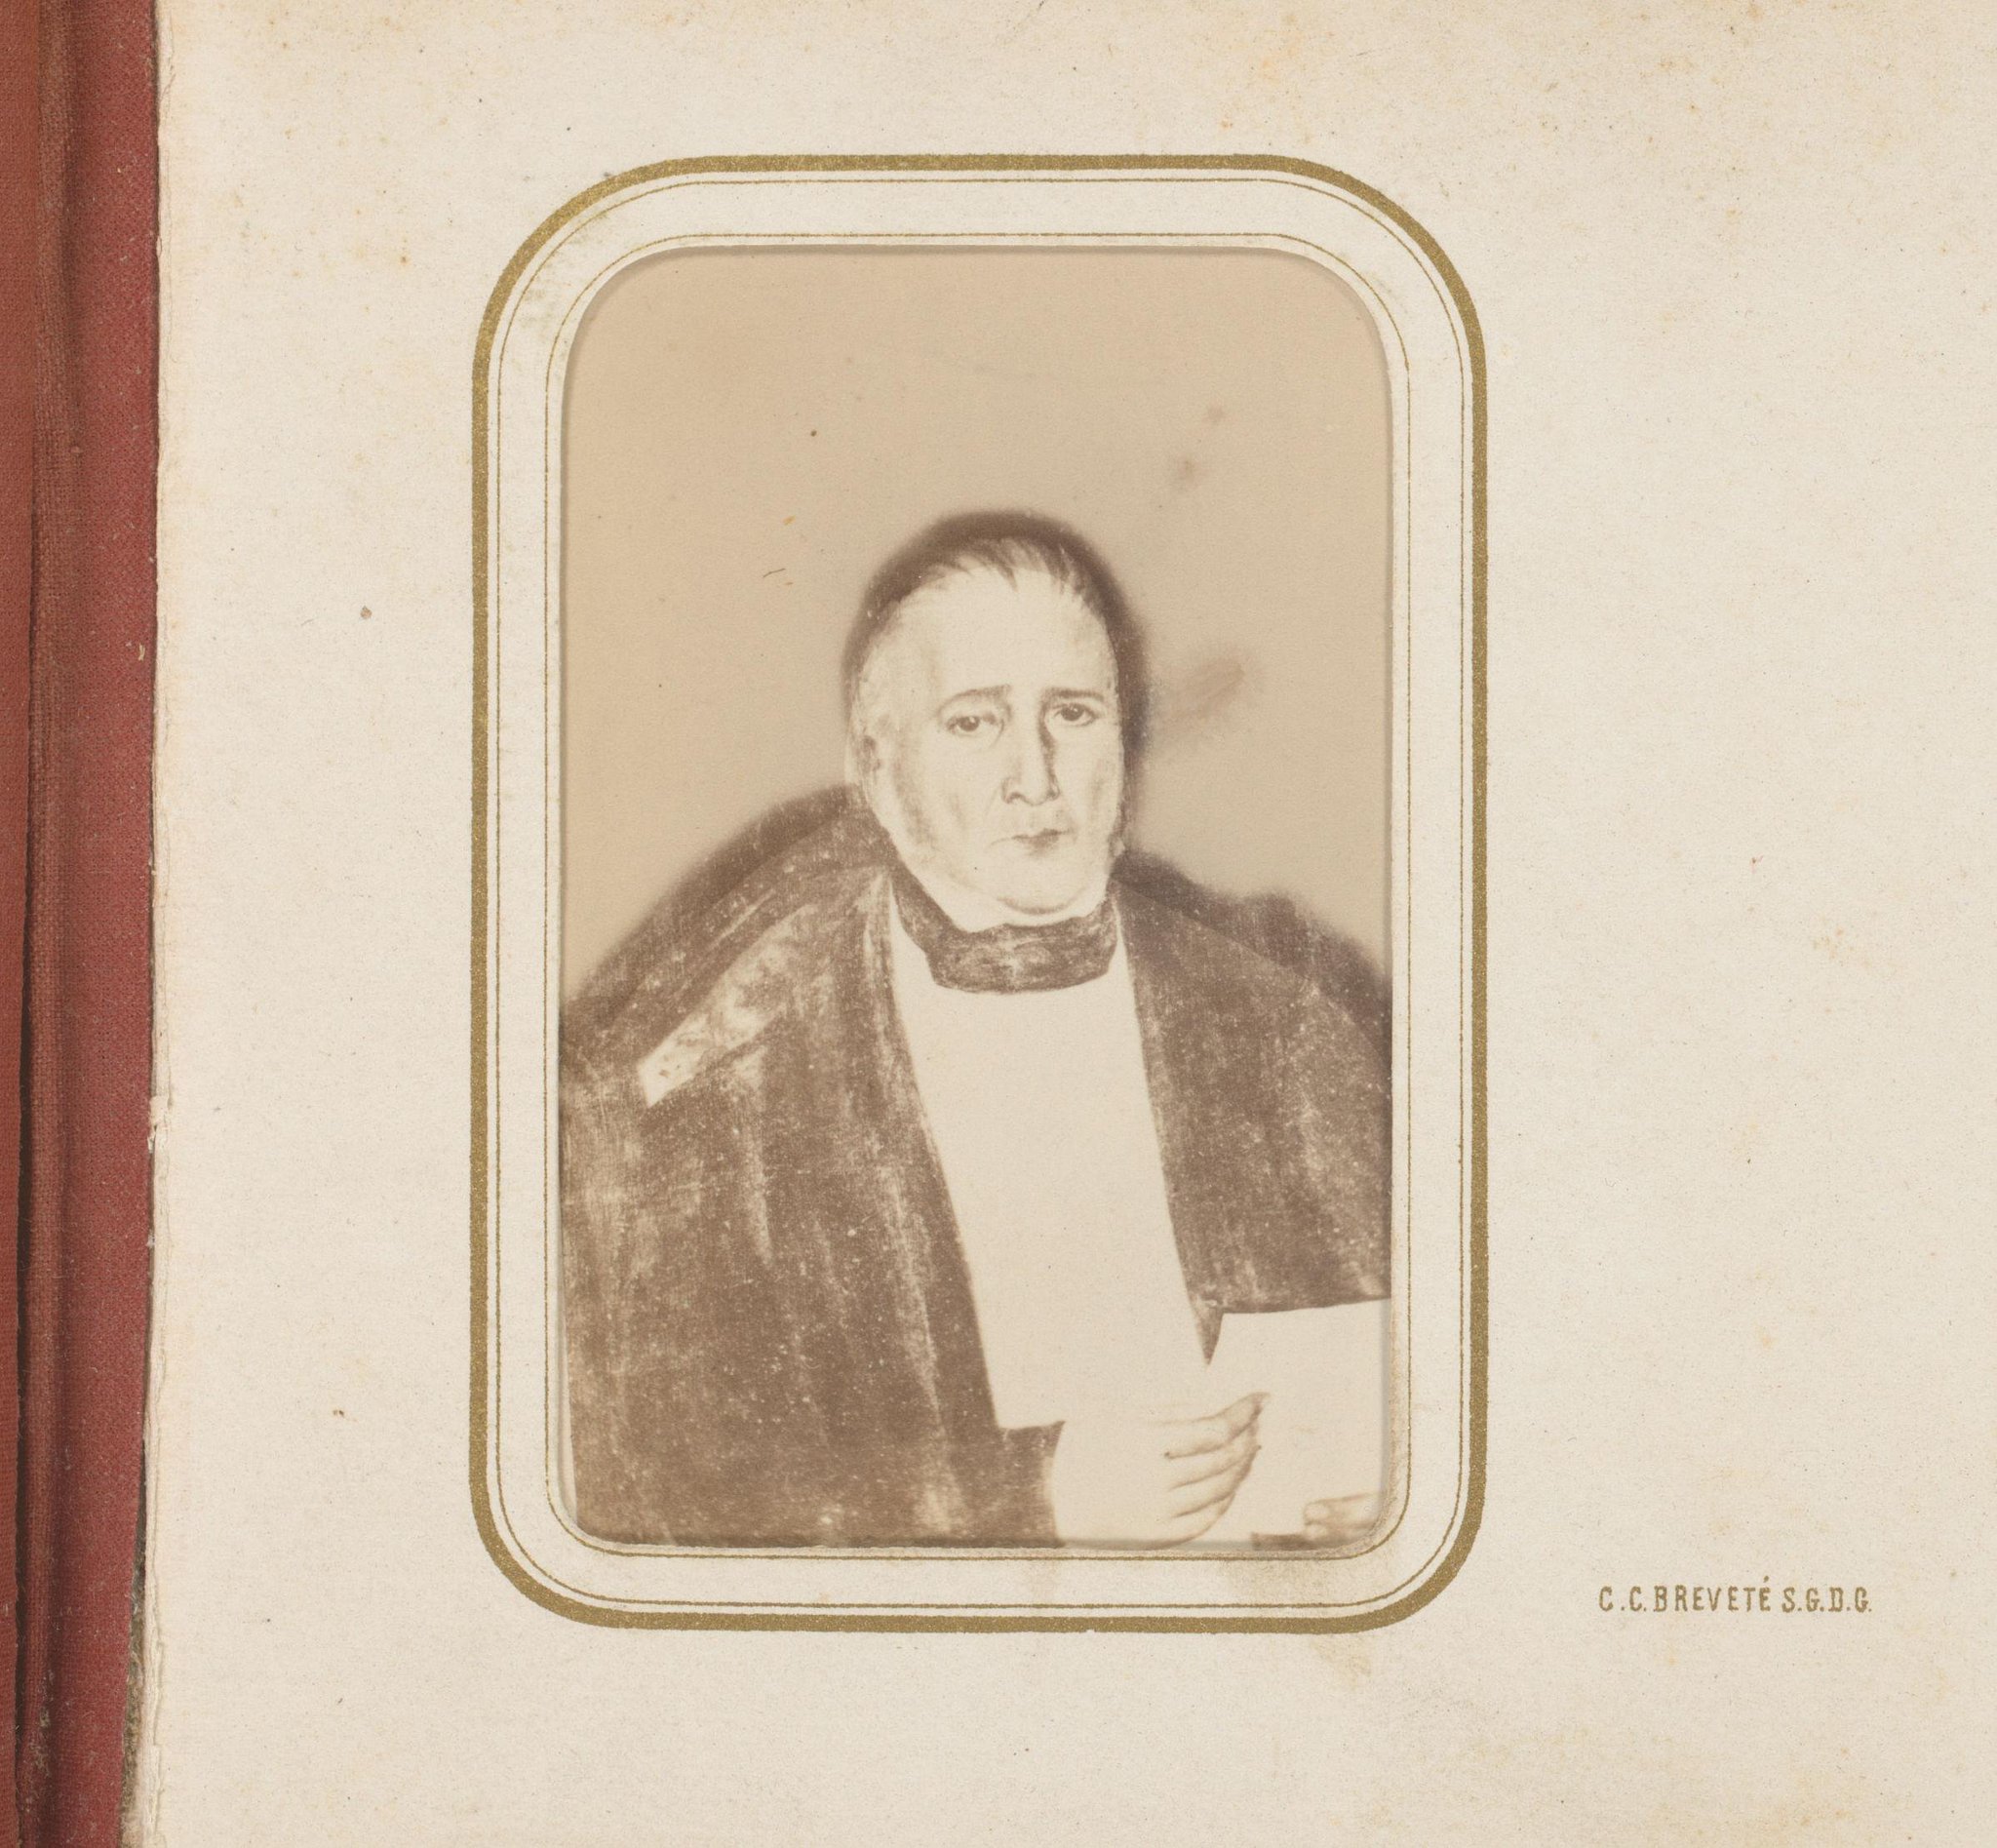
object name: album leaf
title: Portret van een man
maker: Anonymous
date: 1860-1900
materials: cardboard, photographic support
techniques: albumen print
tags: adult man, historical persons